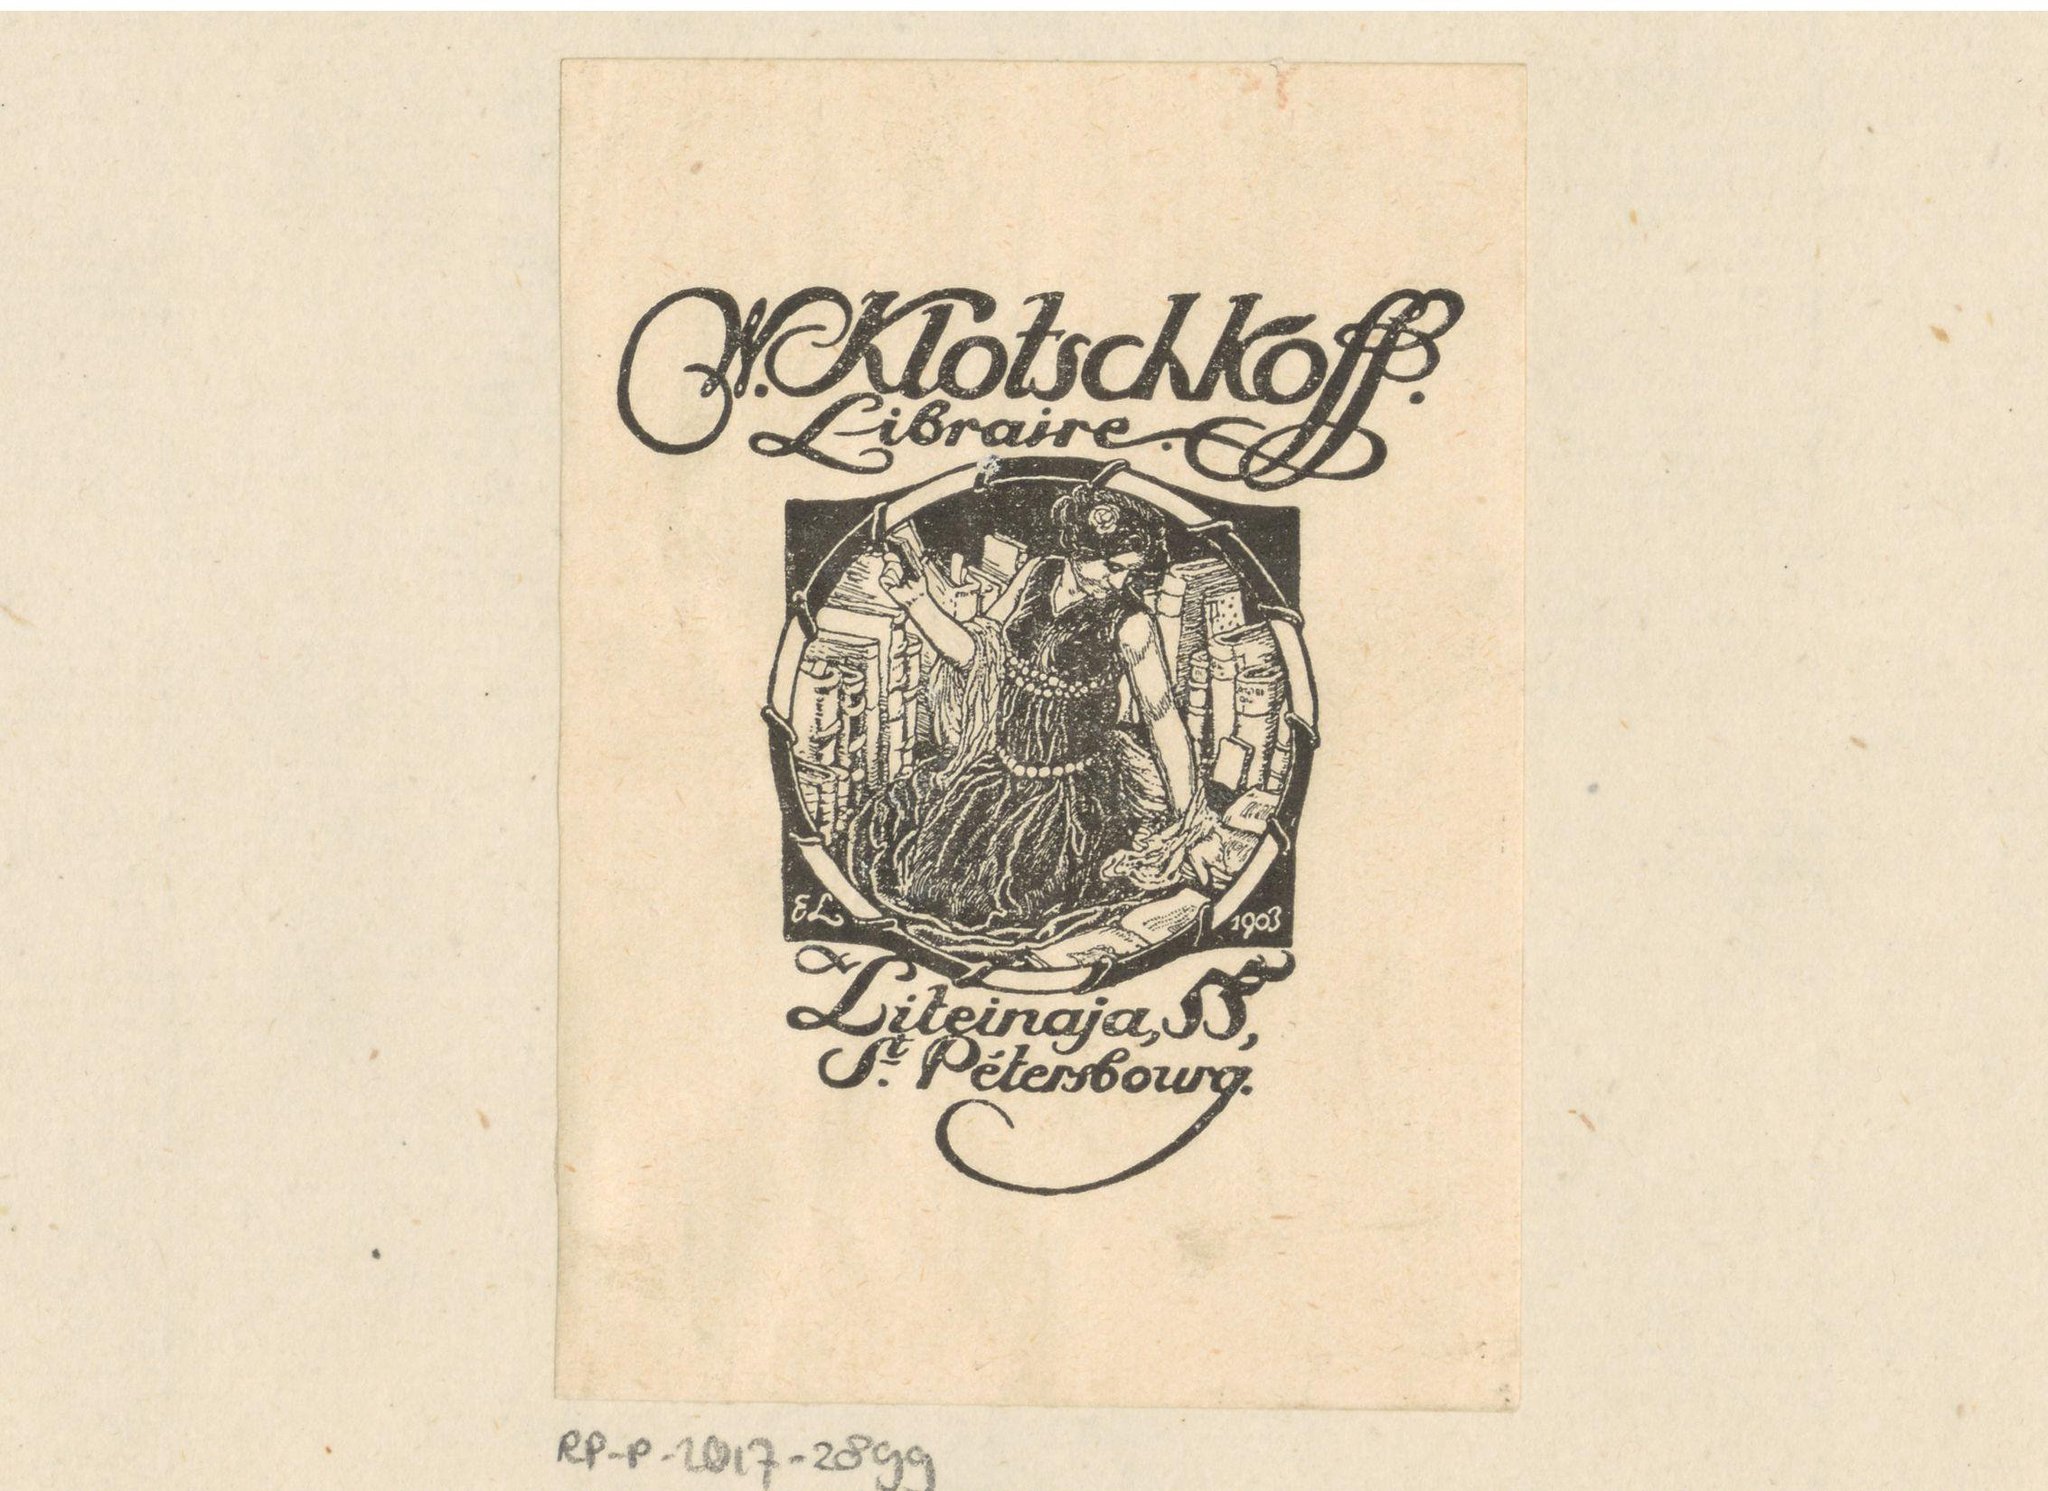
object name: bookplate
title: Ex libris van W. Klotschkoff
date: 1903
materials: paper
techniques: printing block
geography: russia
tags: sitting figure - aa - female human figure, book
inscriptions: date